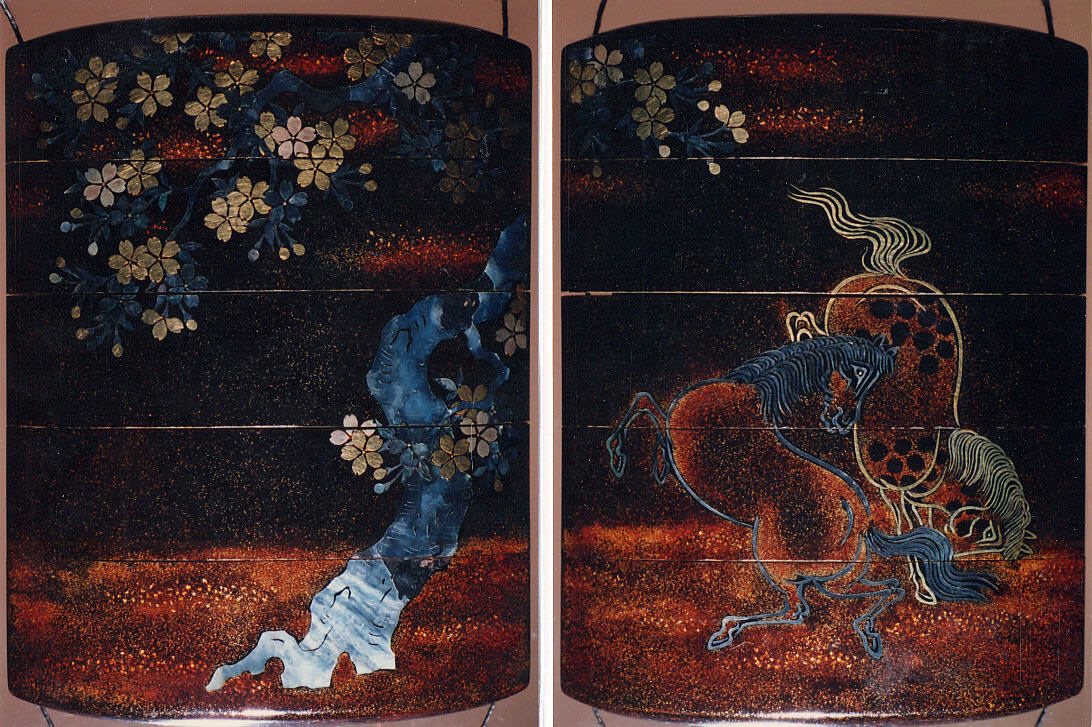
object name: inrō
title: Case (Inrō) with Design of Two Horses Beneath Flowering Cherry Tree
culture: japanese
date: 1801-1900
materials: gold foil, lacquer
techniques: fundame, roiro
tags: horses,flowers,trees